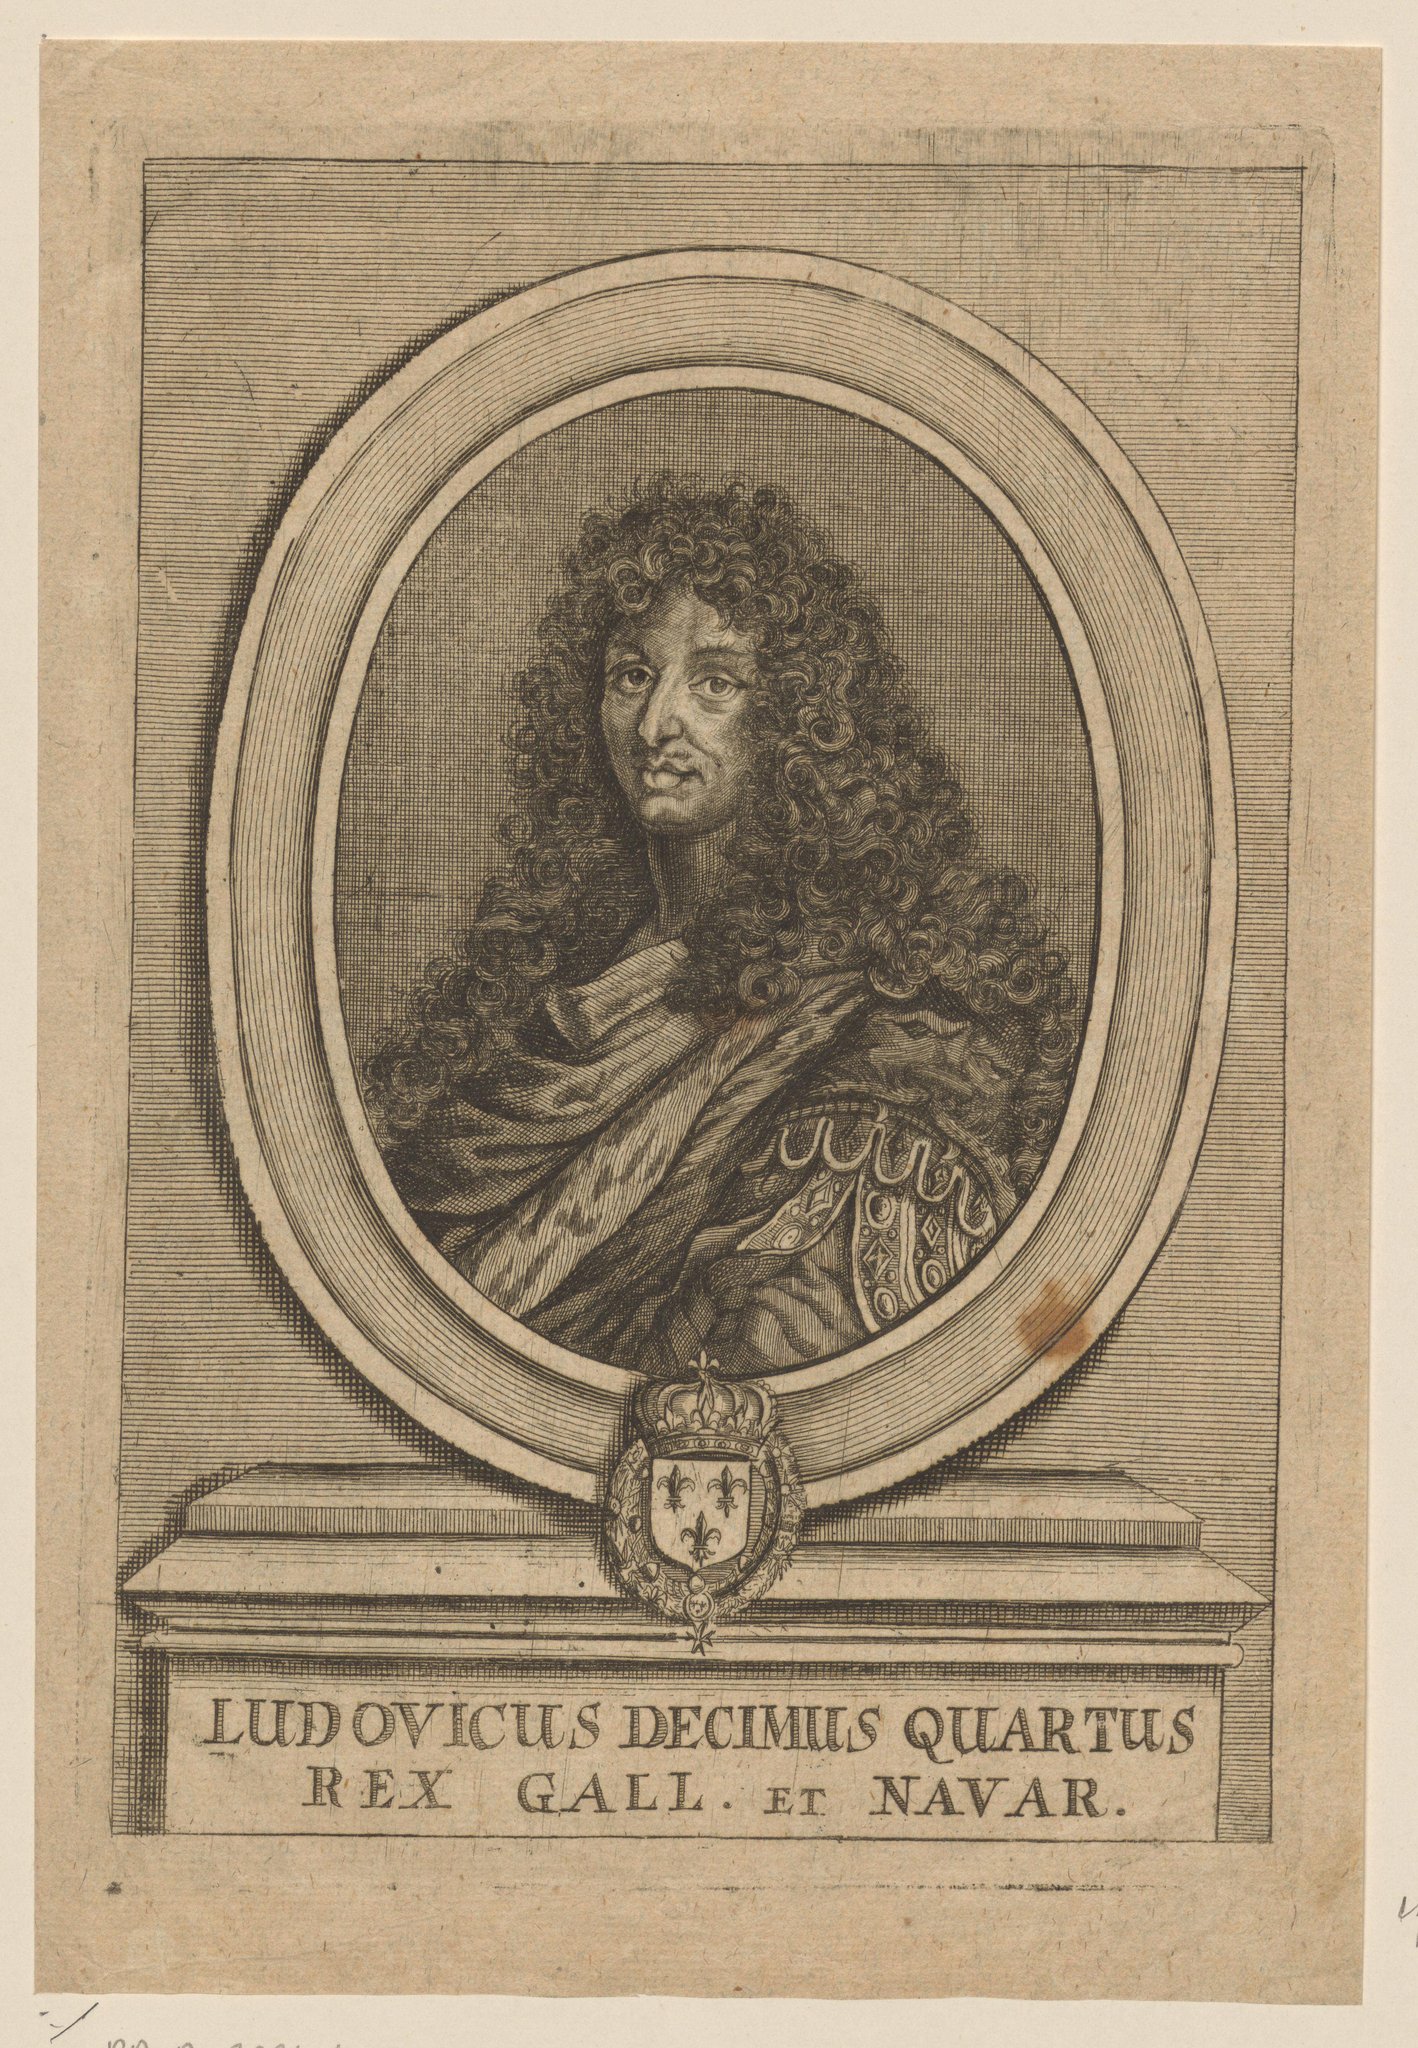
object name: print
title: Portret van Lodewijk XIV van Frankrijk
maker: Anonymous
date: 1709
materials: paper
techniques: engraving, etching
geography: germany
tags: lodewijk xiv (koning van frankrijk), ornament ~ medallion, historical persons, king, armorial bearing, heraldry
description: Prent waarschijnlijk uit: Cortrejus, Adam. Observata ad pacem publicam (...). Frankfurt am Main: erven Johann Grosse, 1709.